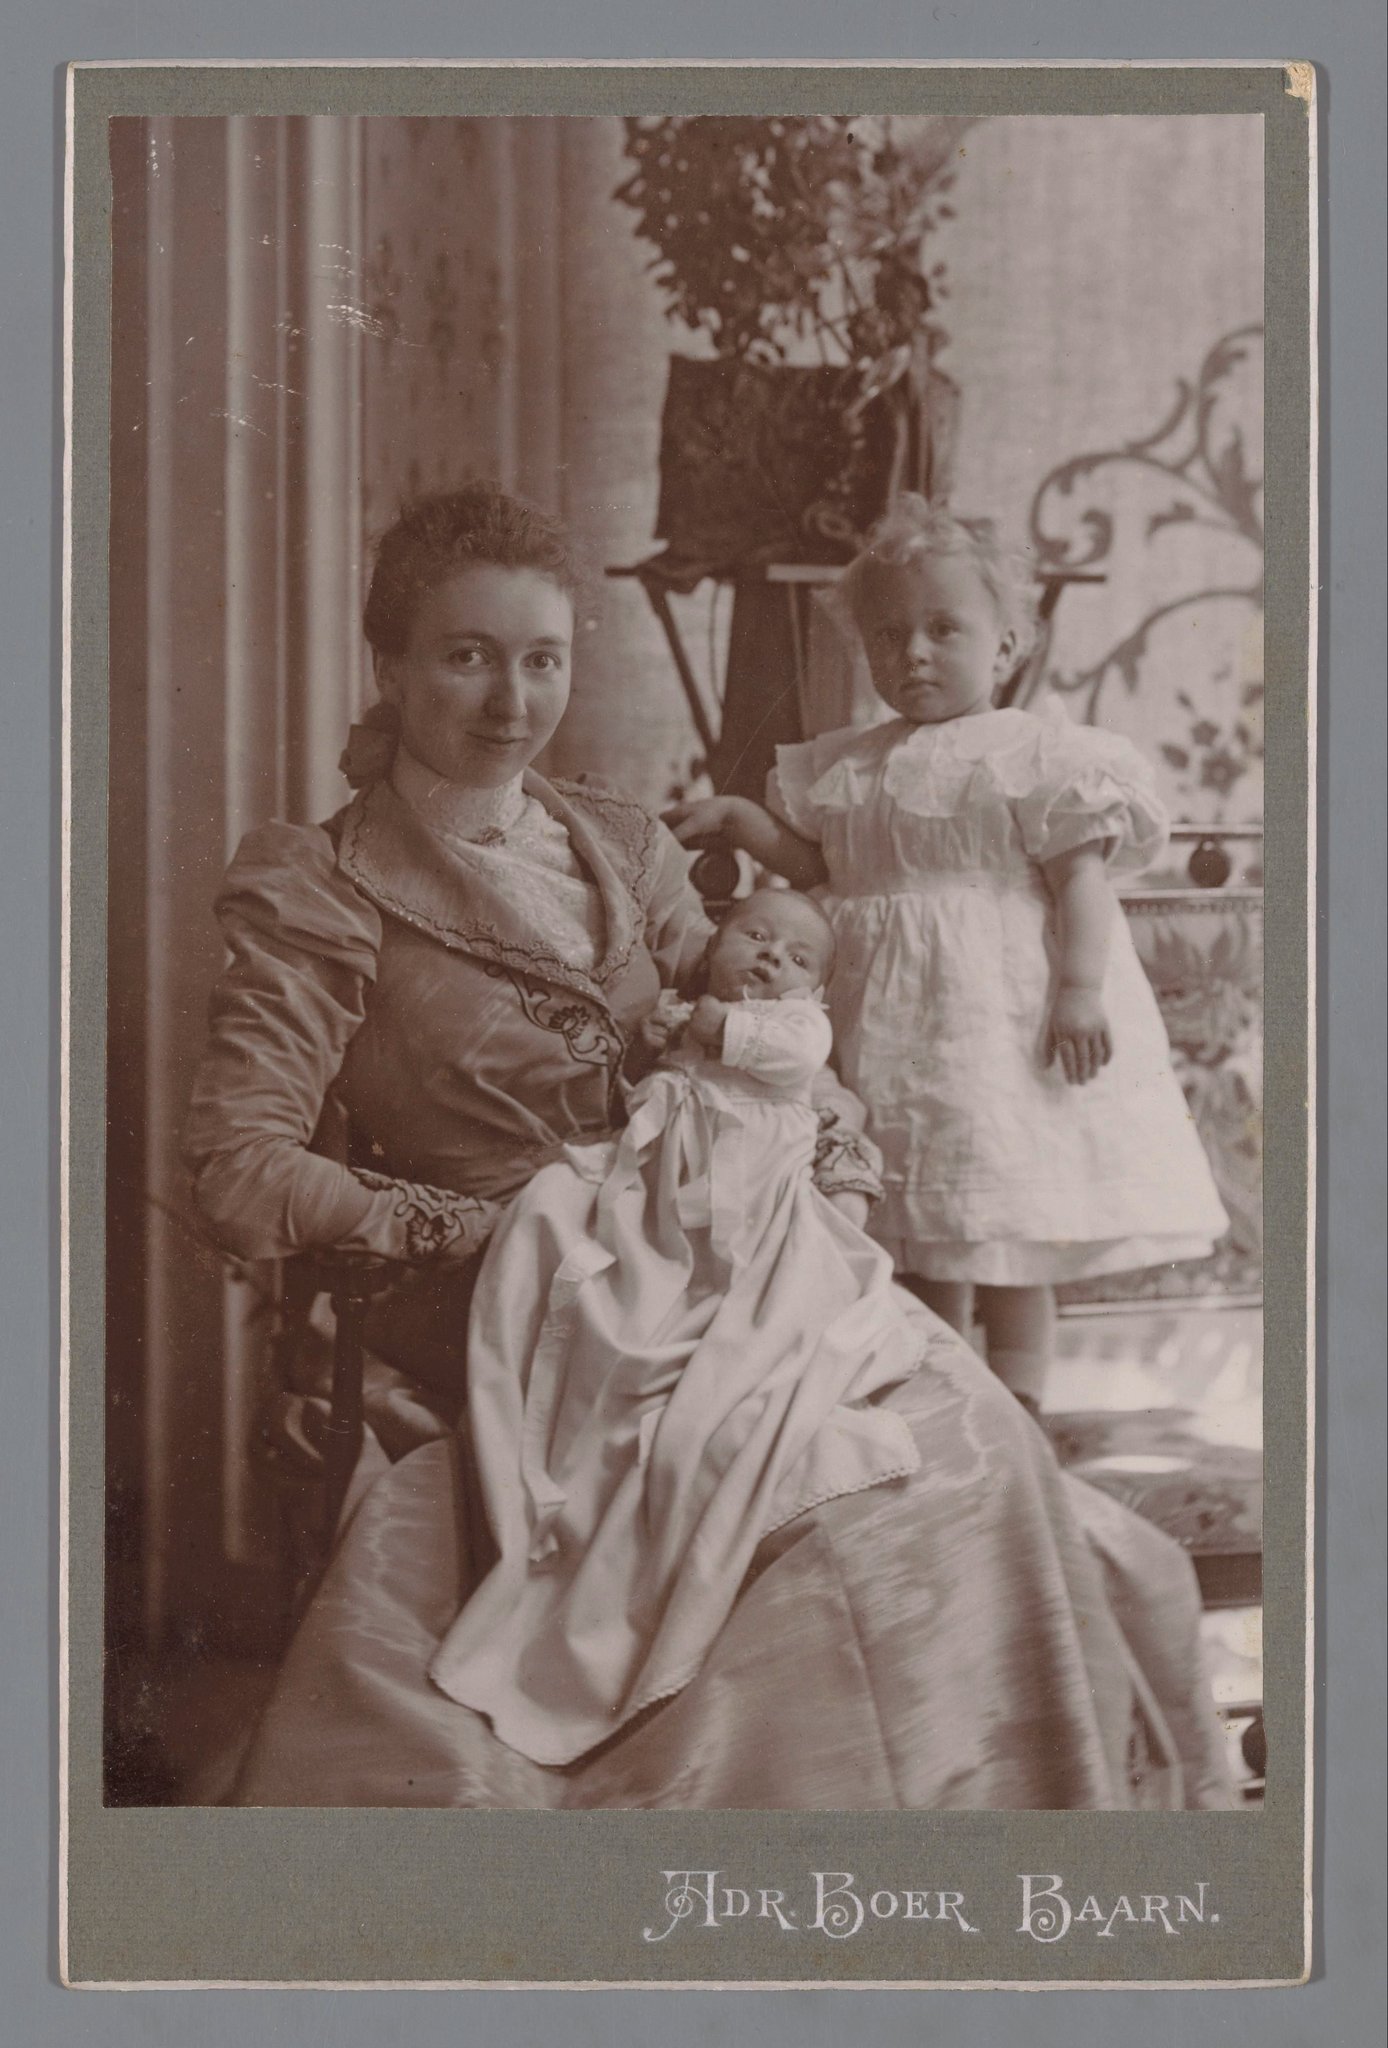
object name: cabinet photograph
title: Portret van een onbekende vrouw met twee kinderen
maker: adriaan boer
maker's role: fotograaf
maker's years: 1875-1940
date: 1887-1912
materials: cardboard, photographic support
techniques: collodion silver print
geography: baarn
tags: mother and baby or young child